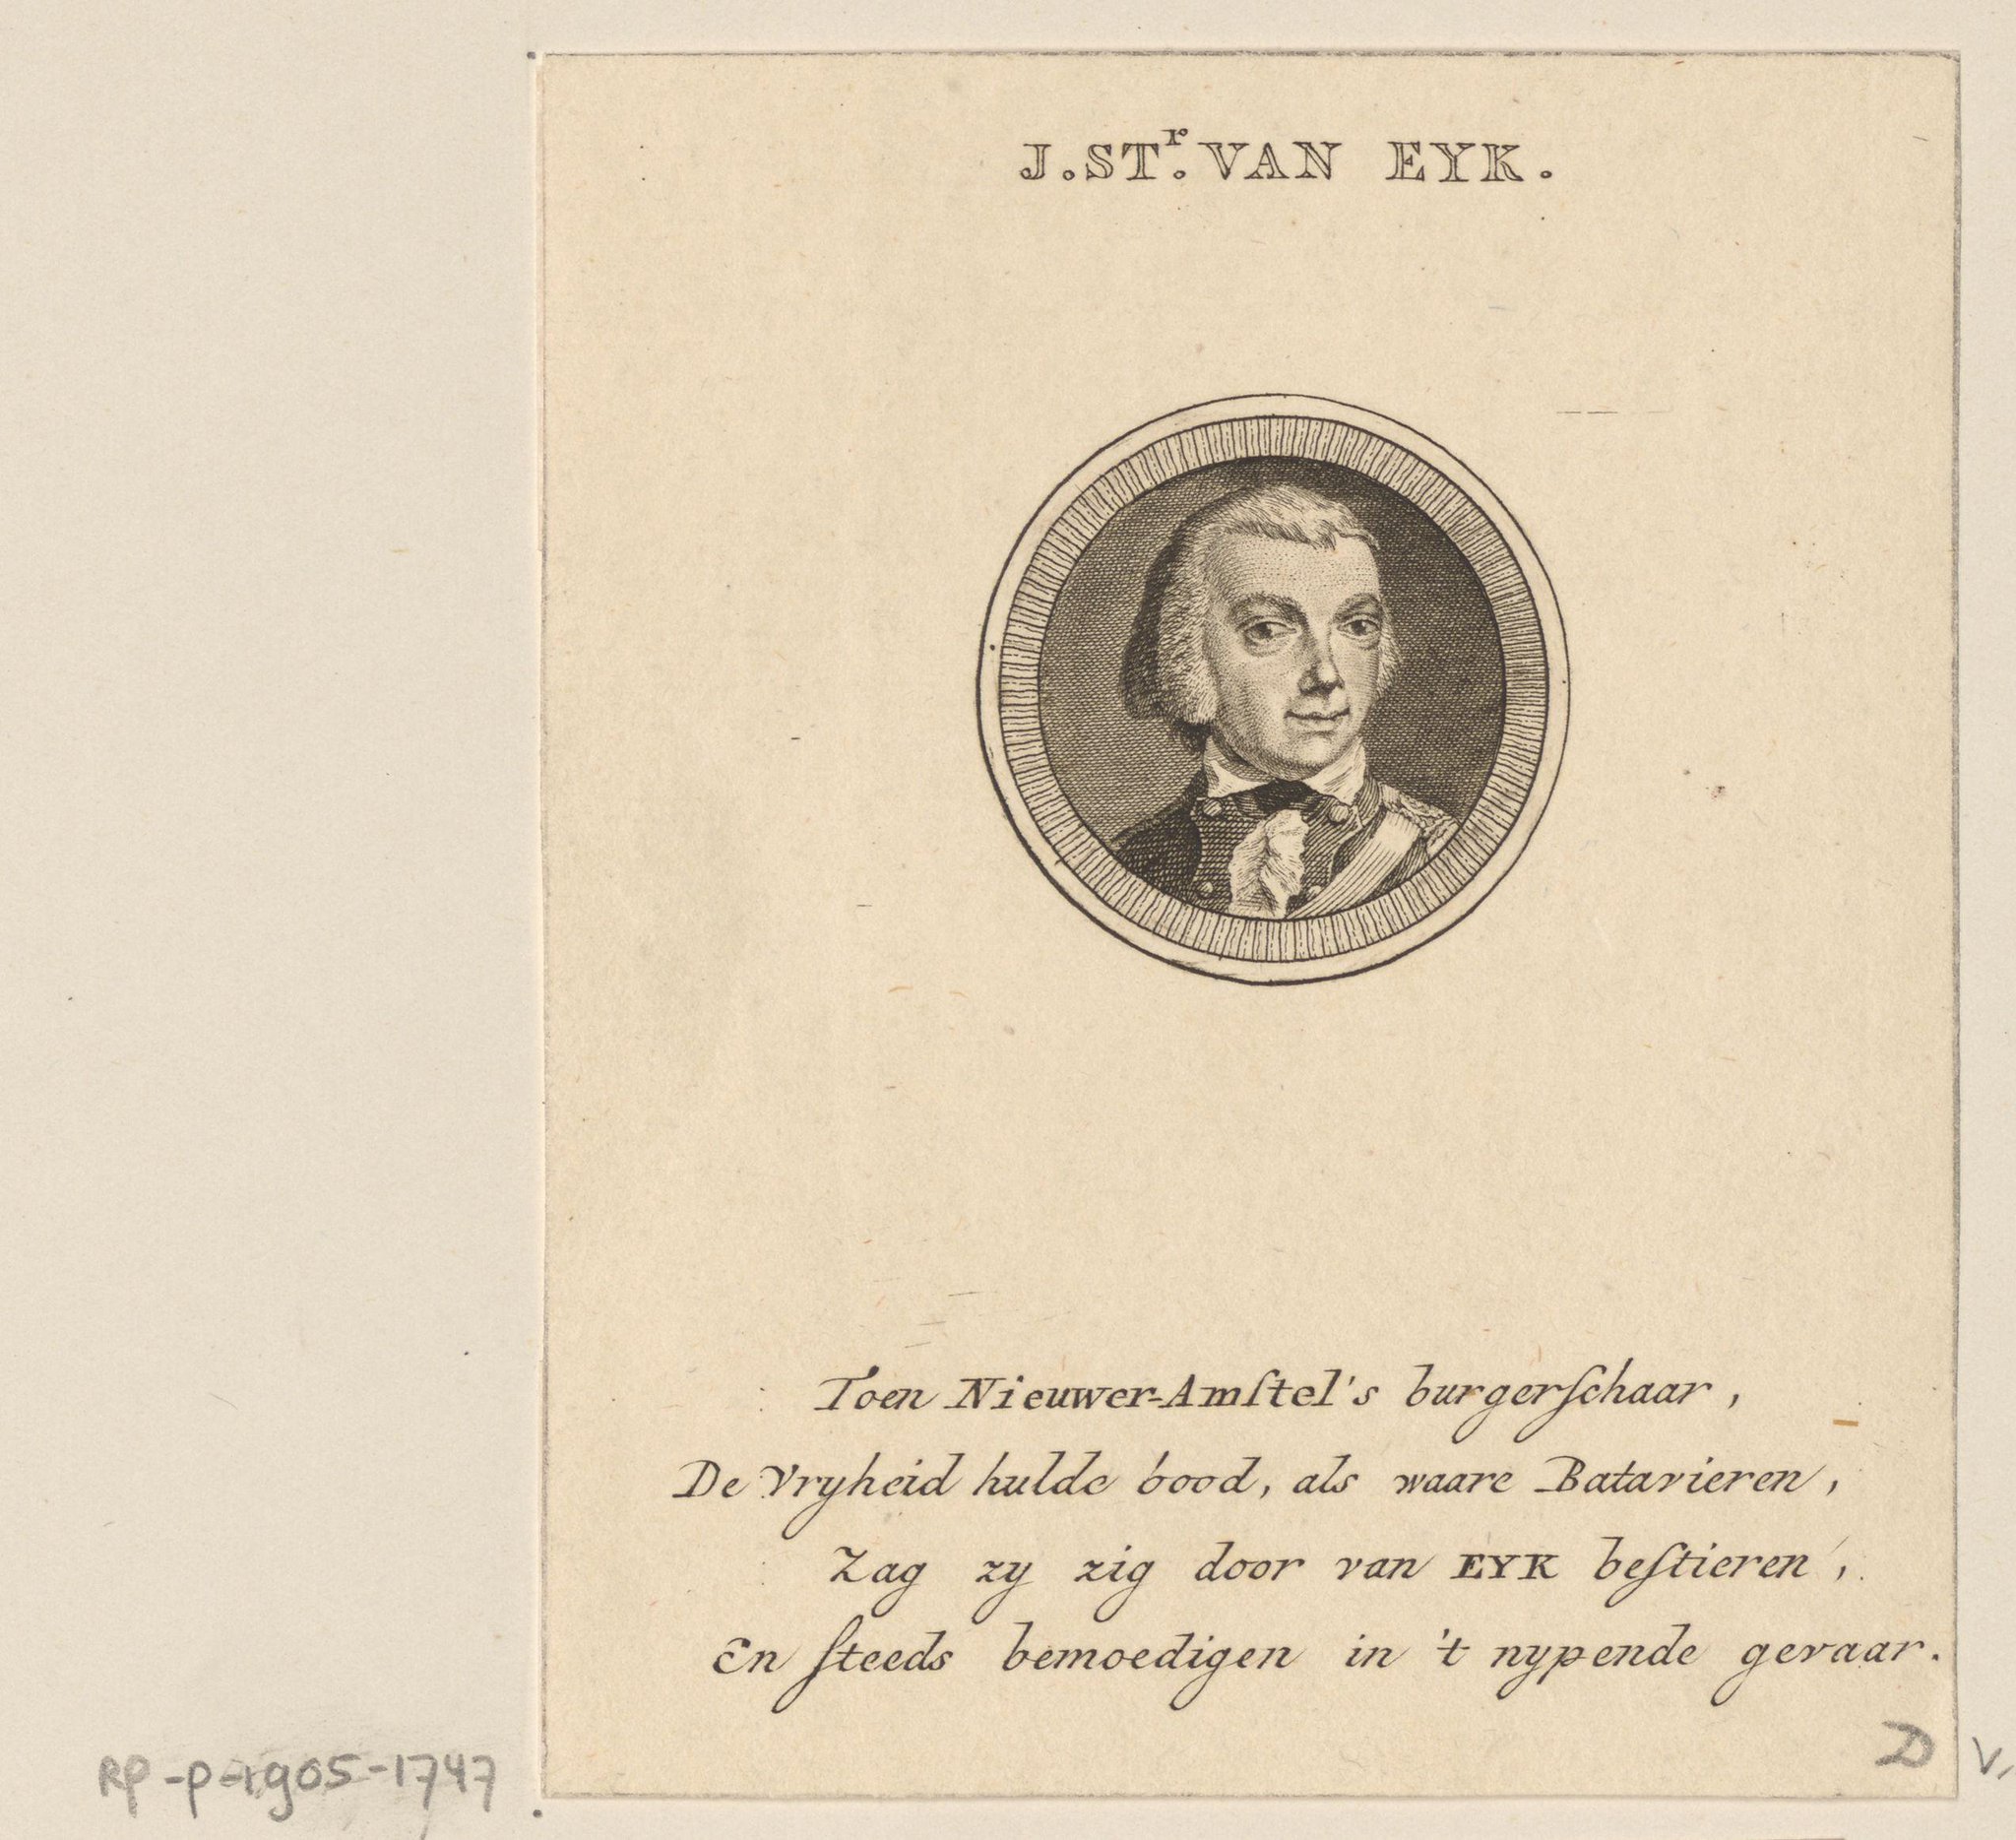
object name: print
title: Verzameling van Afbeeldingen van Nederlandsche Mannen, beroemd geworden, wegens hunne Moed en Burgerliefde in de jongstledene Beroerten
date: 1795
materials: paper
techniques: engraving, etching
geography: amsterdam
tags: historical persons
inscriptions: collector's mark: Lugt 2228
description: Jacobus Wijsman heeft sommige platen van de serie patriottenportretten van Abraham Jacobsz. Hulk aangepast en hergebruikt in zijn eigen serie patriottenportretten. Prent maakt deel uit van een serie, die in drie afleveringen werd uitgegeven onder de titel: Verzameling van Afbeeldingen van Nederlandsche Mannen, beroemd geworden, wegens hunne Moed en Burgerliefde in de jongstledene Beroerten. 1794-1795. Zie Atlas van Stolk en Van Someren.